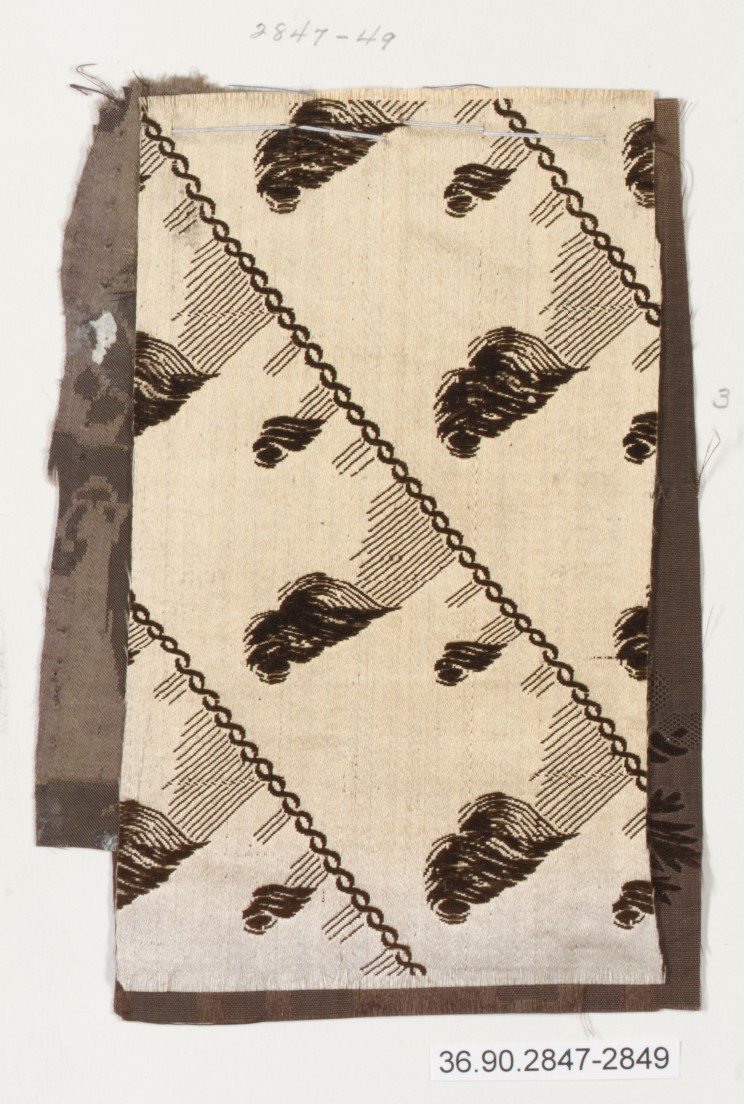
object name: piece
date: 1801-1900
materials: silk